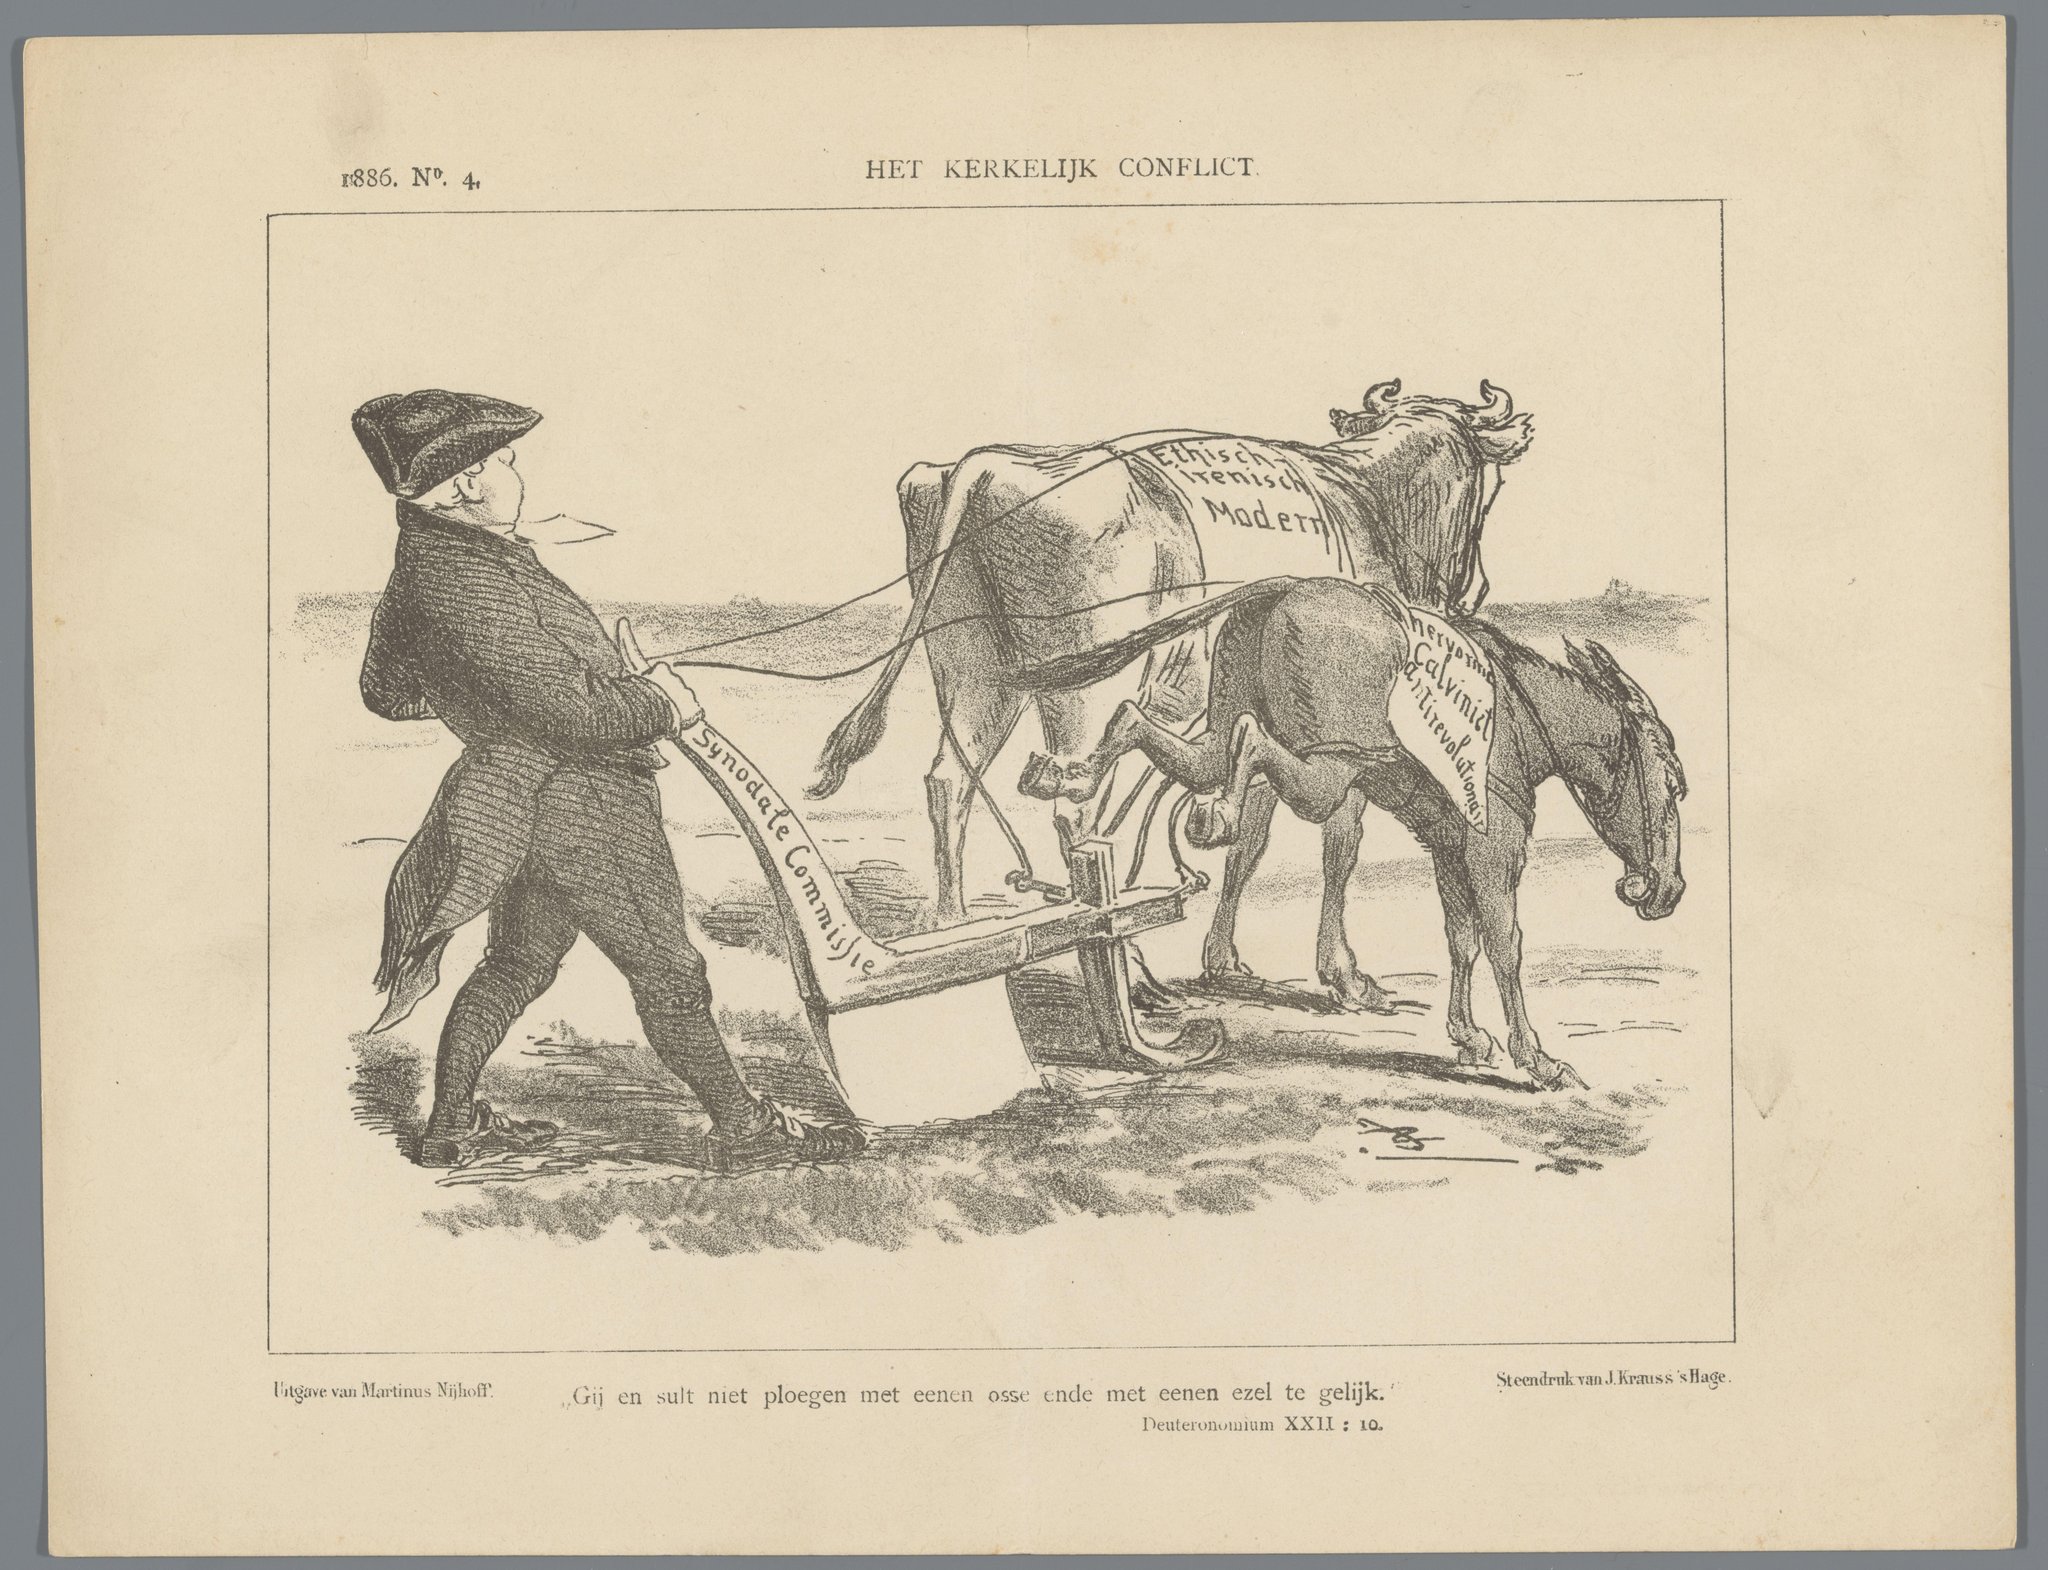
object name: print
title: Het kerkelijk conflict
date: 1886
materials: paper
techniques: lithograph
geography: netherlands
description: Spotprent over een kerkelijk conflict, 1886. Plaat verschenen bij het weekblad De Nederlandsche Spectator, nr. 4, 1886.